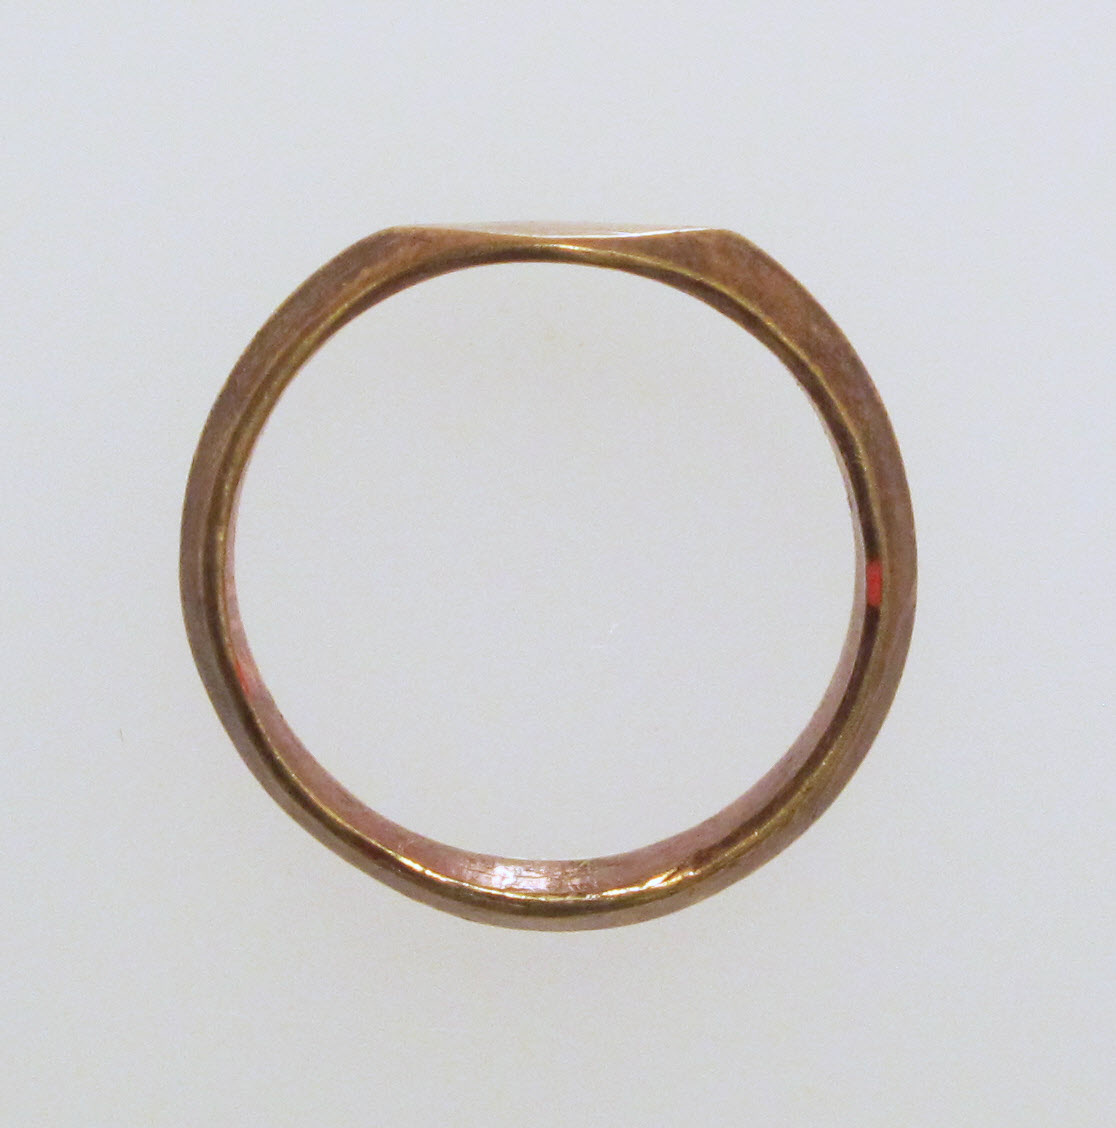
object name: ring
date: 7000 BCE-330 CE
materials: gold